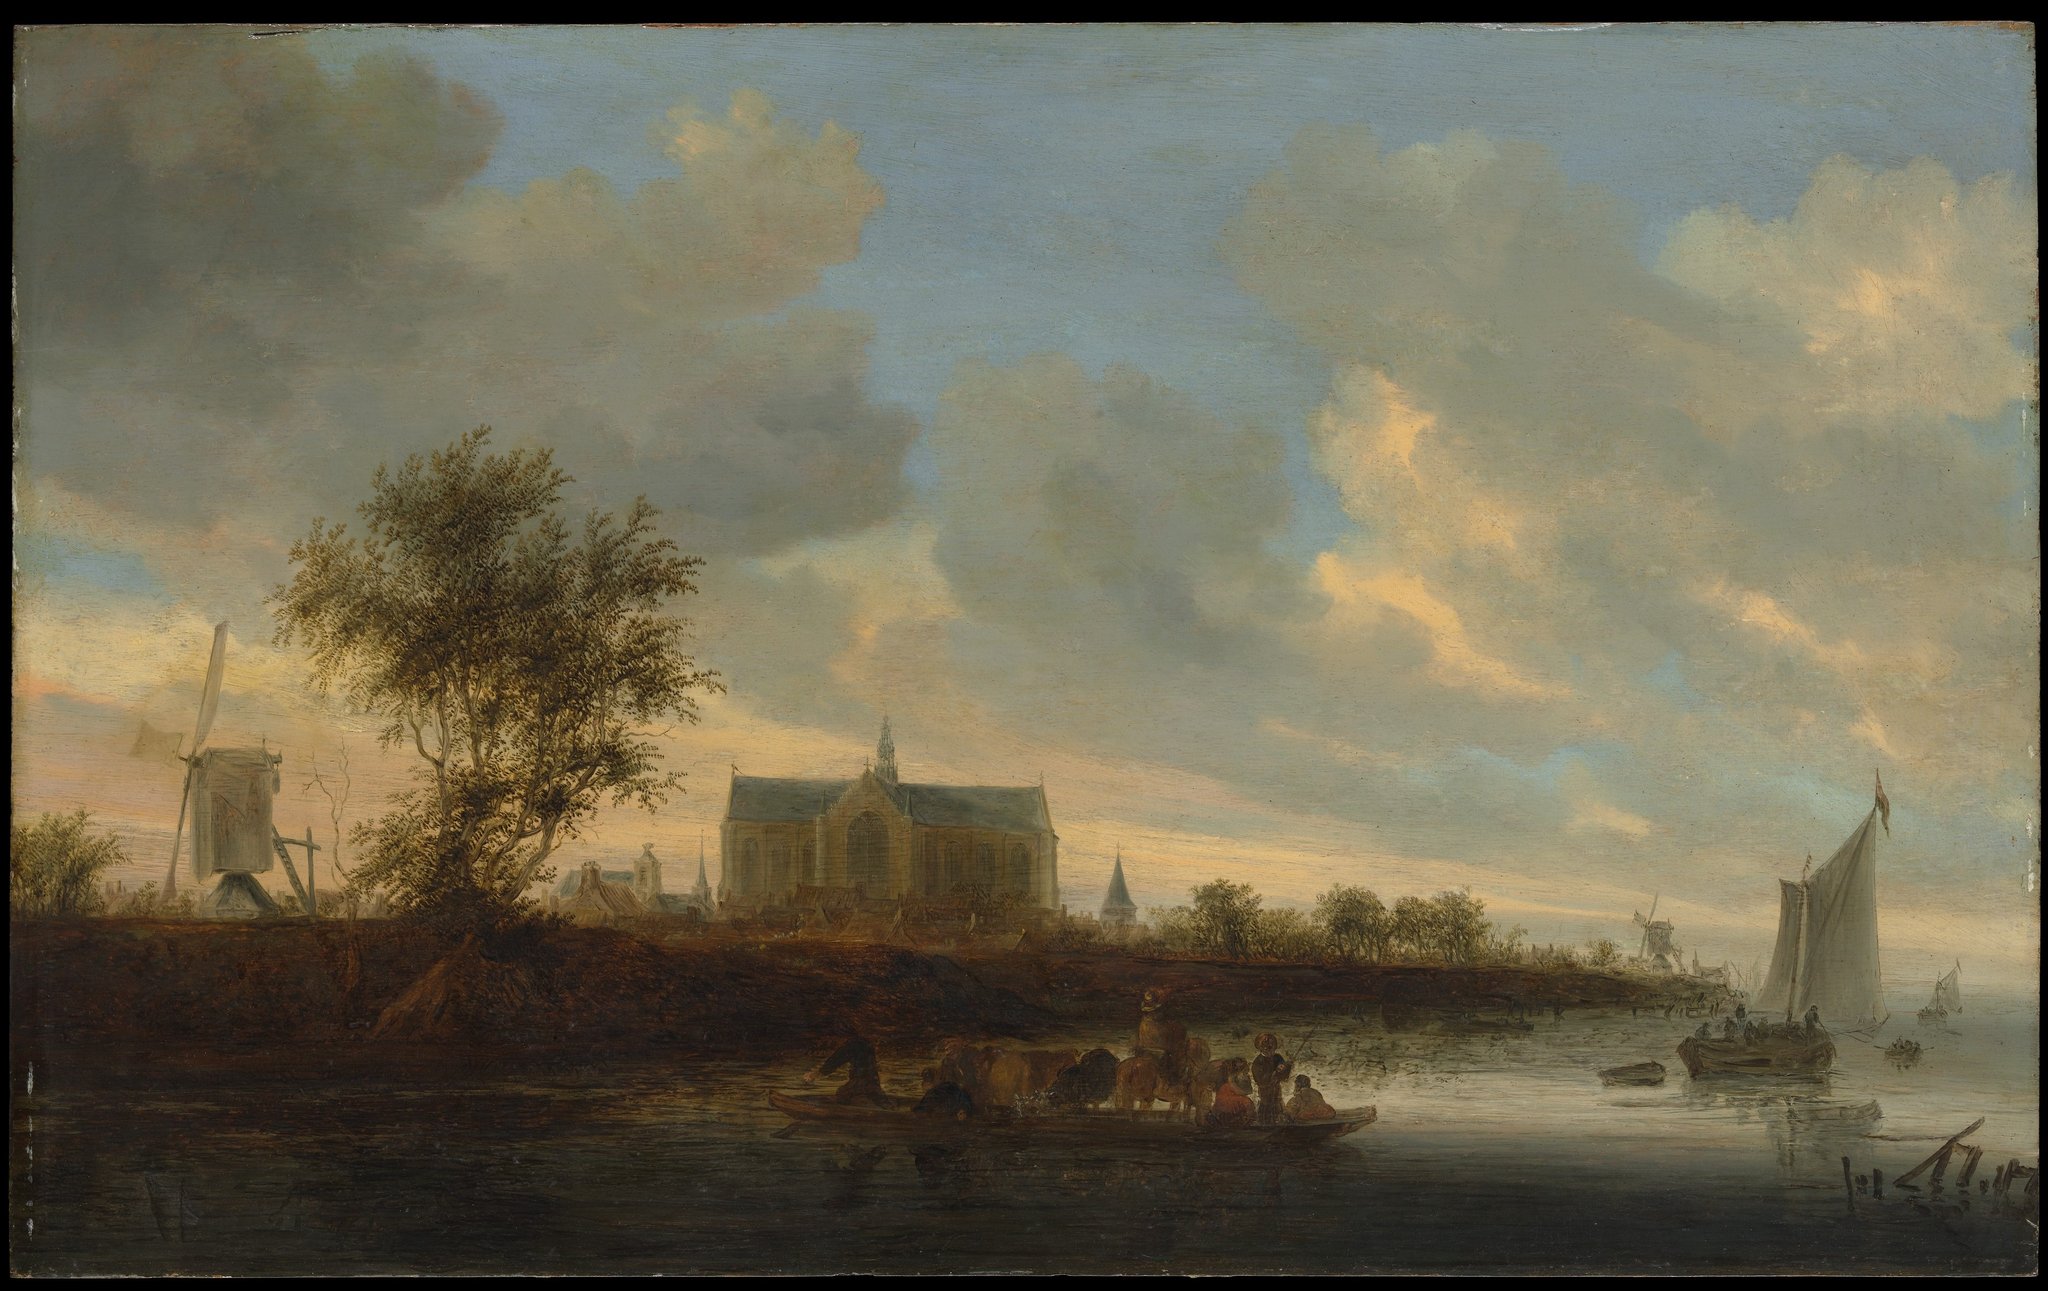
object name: painting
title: View of the Town of Alkmaar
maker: salomon van ruysdael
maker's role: artist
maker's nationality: dutch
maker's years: 1600-1670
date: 1620-1670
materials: oil, wood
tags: buildings,towns,rivers,boats